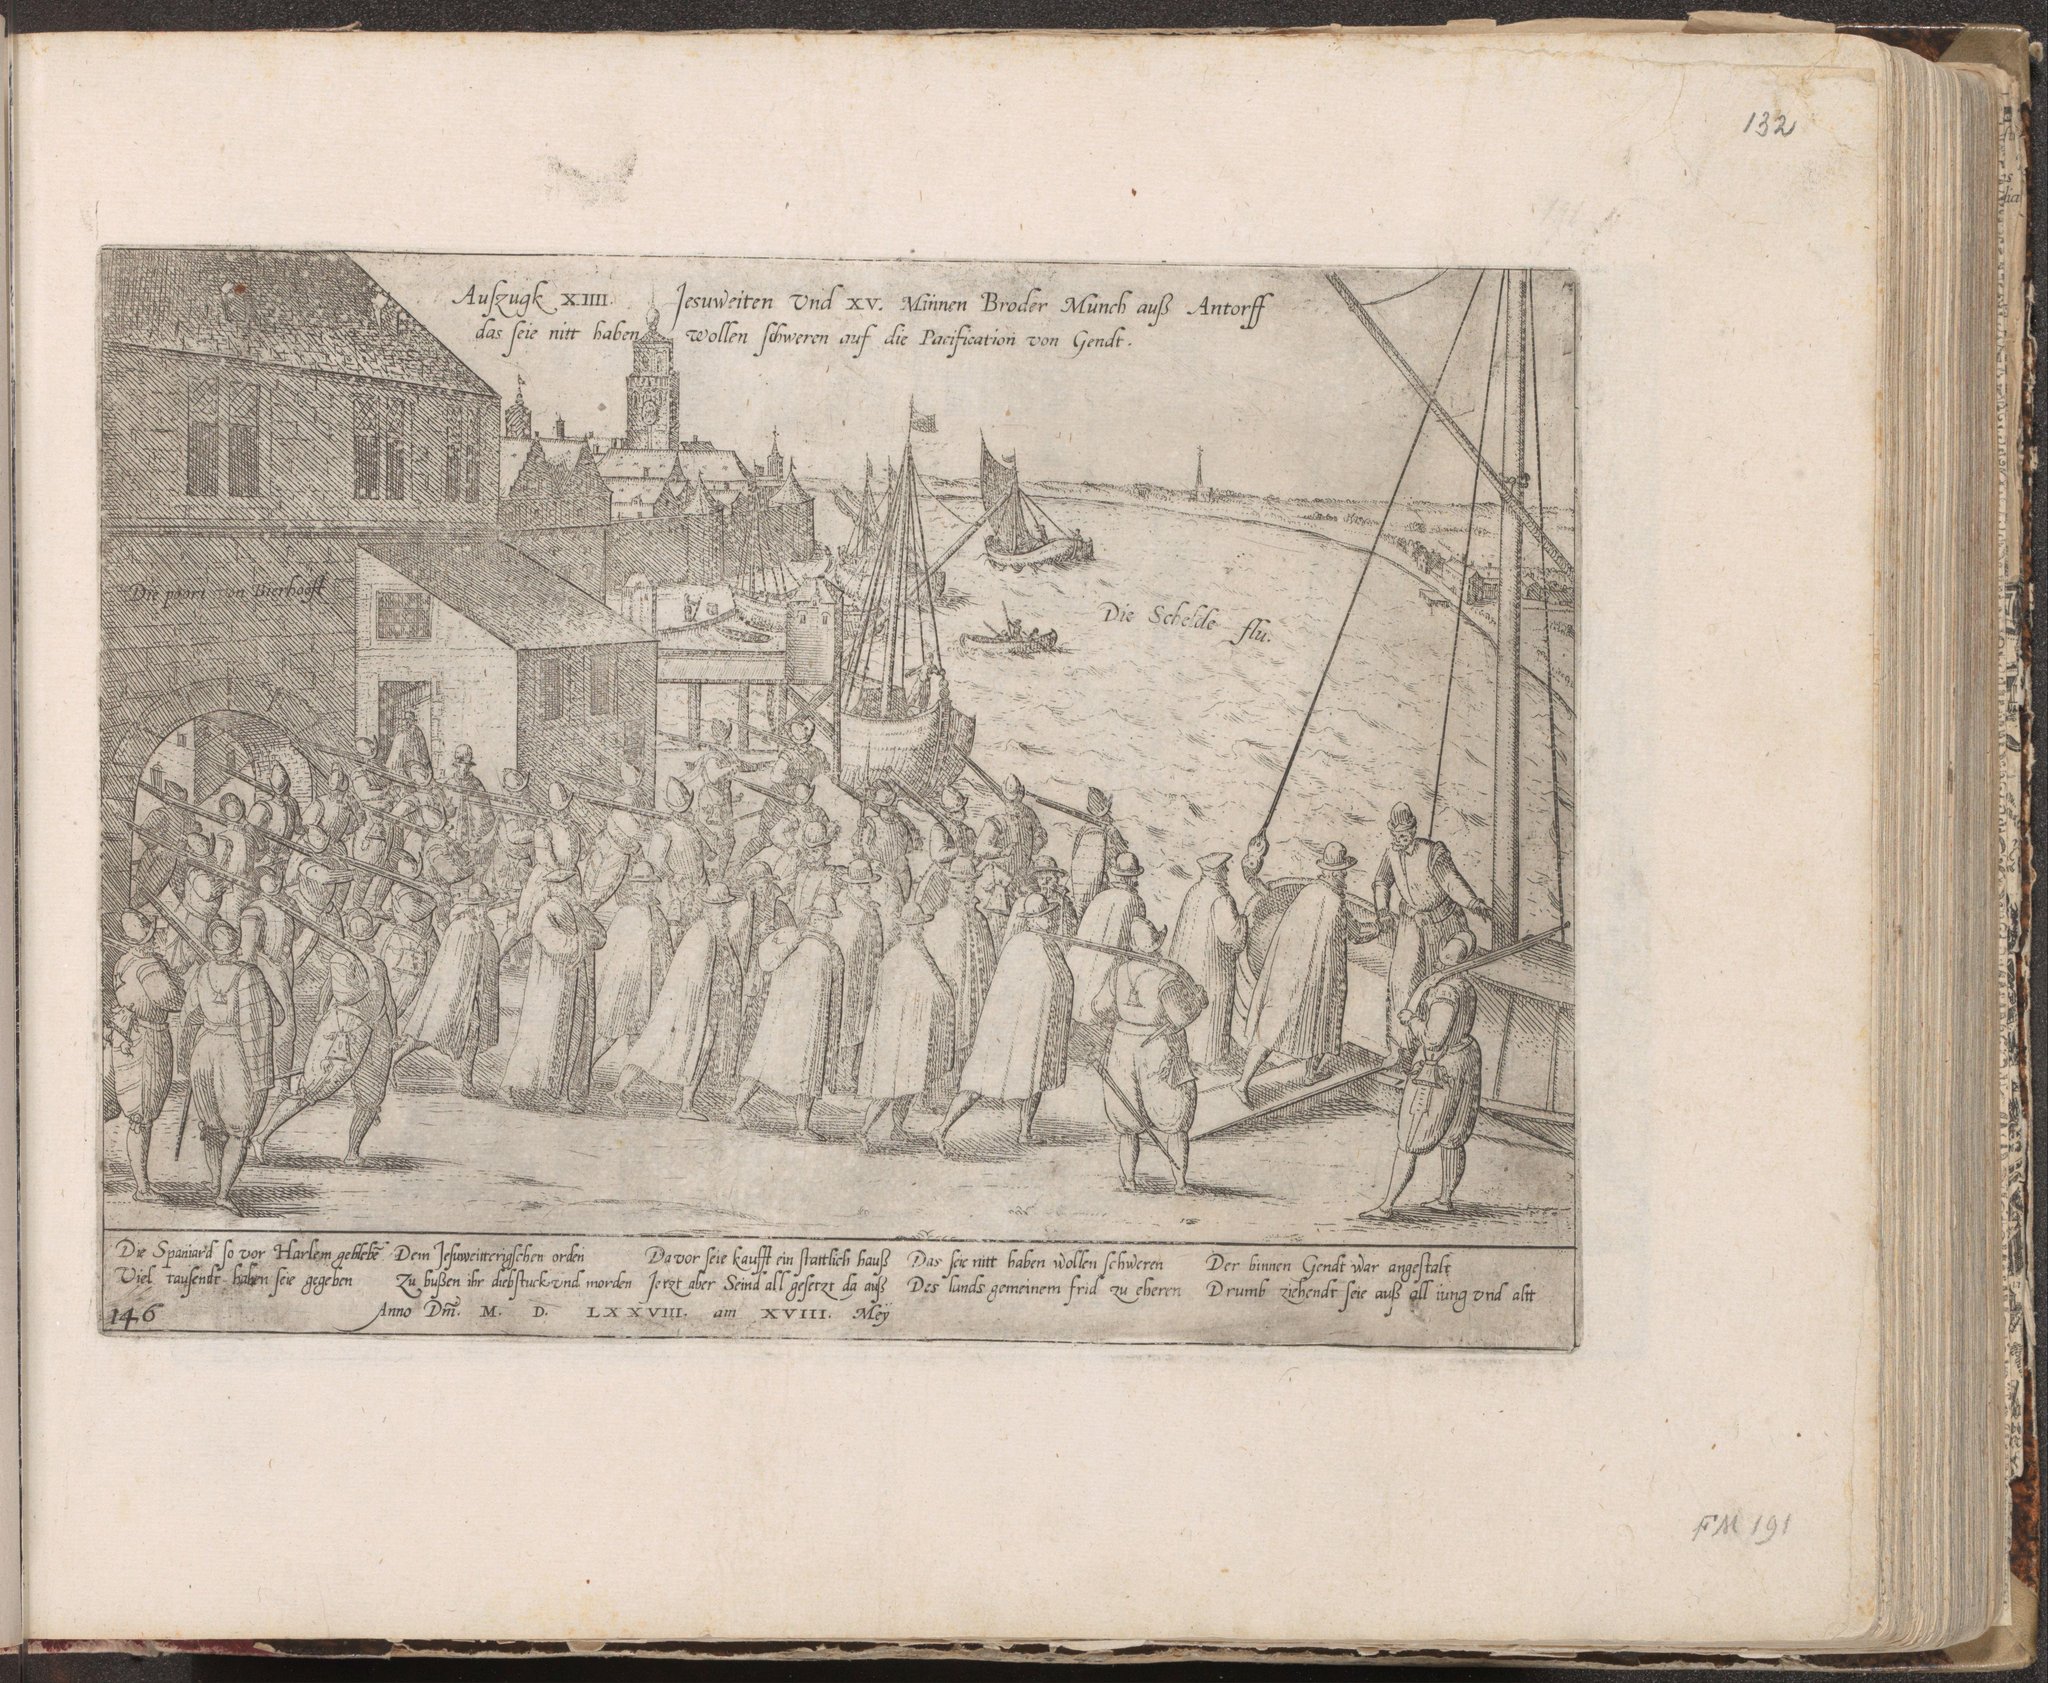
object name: history print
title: Aufzugk XIIII Jesuweiten und XV Minnen Broder Munch auß Antorff das seie nitt haben wollen schweren auf die Pacification von Gendt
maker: frans hogenberg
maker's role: print maker, publisher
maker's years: 1538-1590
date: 1581-1585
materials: paper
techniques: etching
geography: cologne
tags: monk(s), friar(s), antwerp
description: Jezuïten en Minderbroeders verlaten onder gewapende begeleiding de stad Antwerpen, 18 mei 1578, na hun weigering om de gehoorzamen aan het preekverbod. Bij de haven gaan ze aan boord van een schuit. Met onderschrift van 10 regels in het Duits. Linksonder genummerd: 146. De prent maakt deel uit van een album.